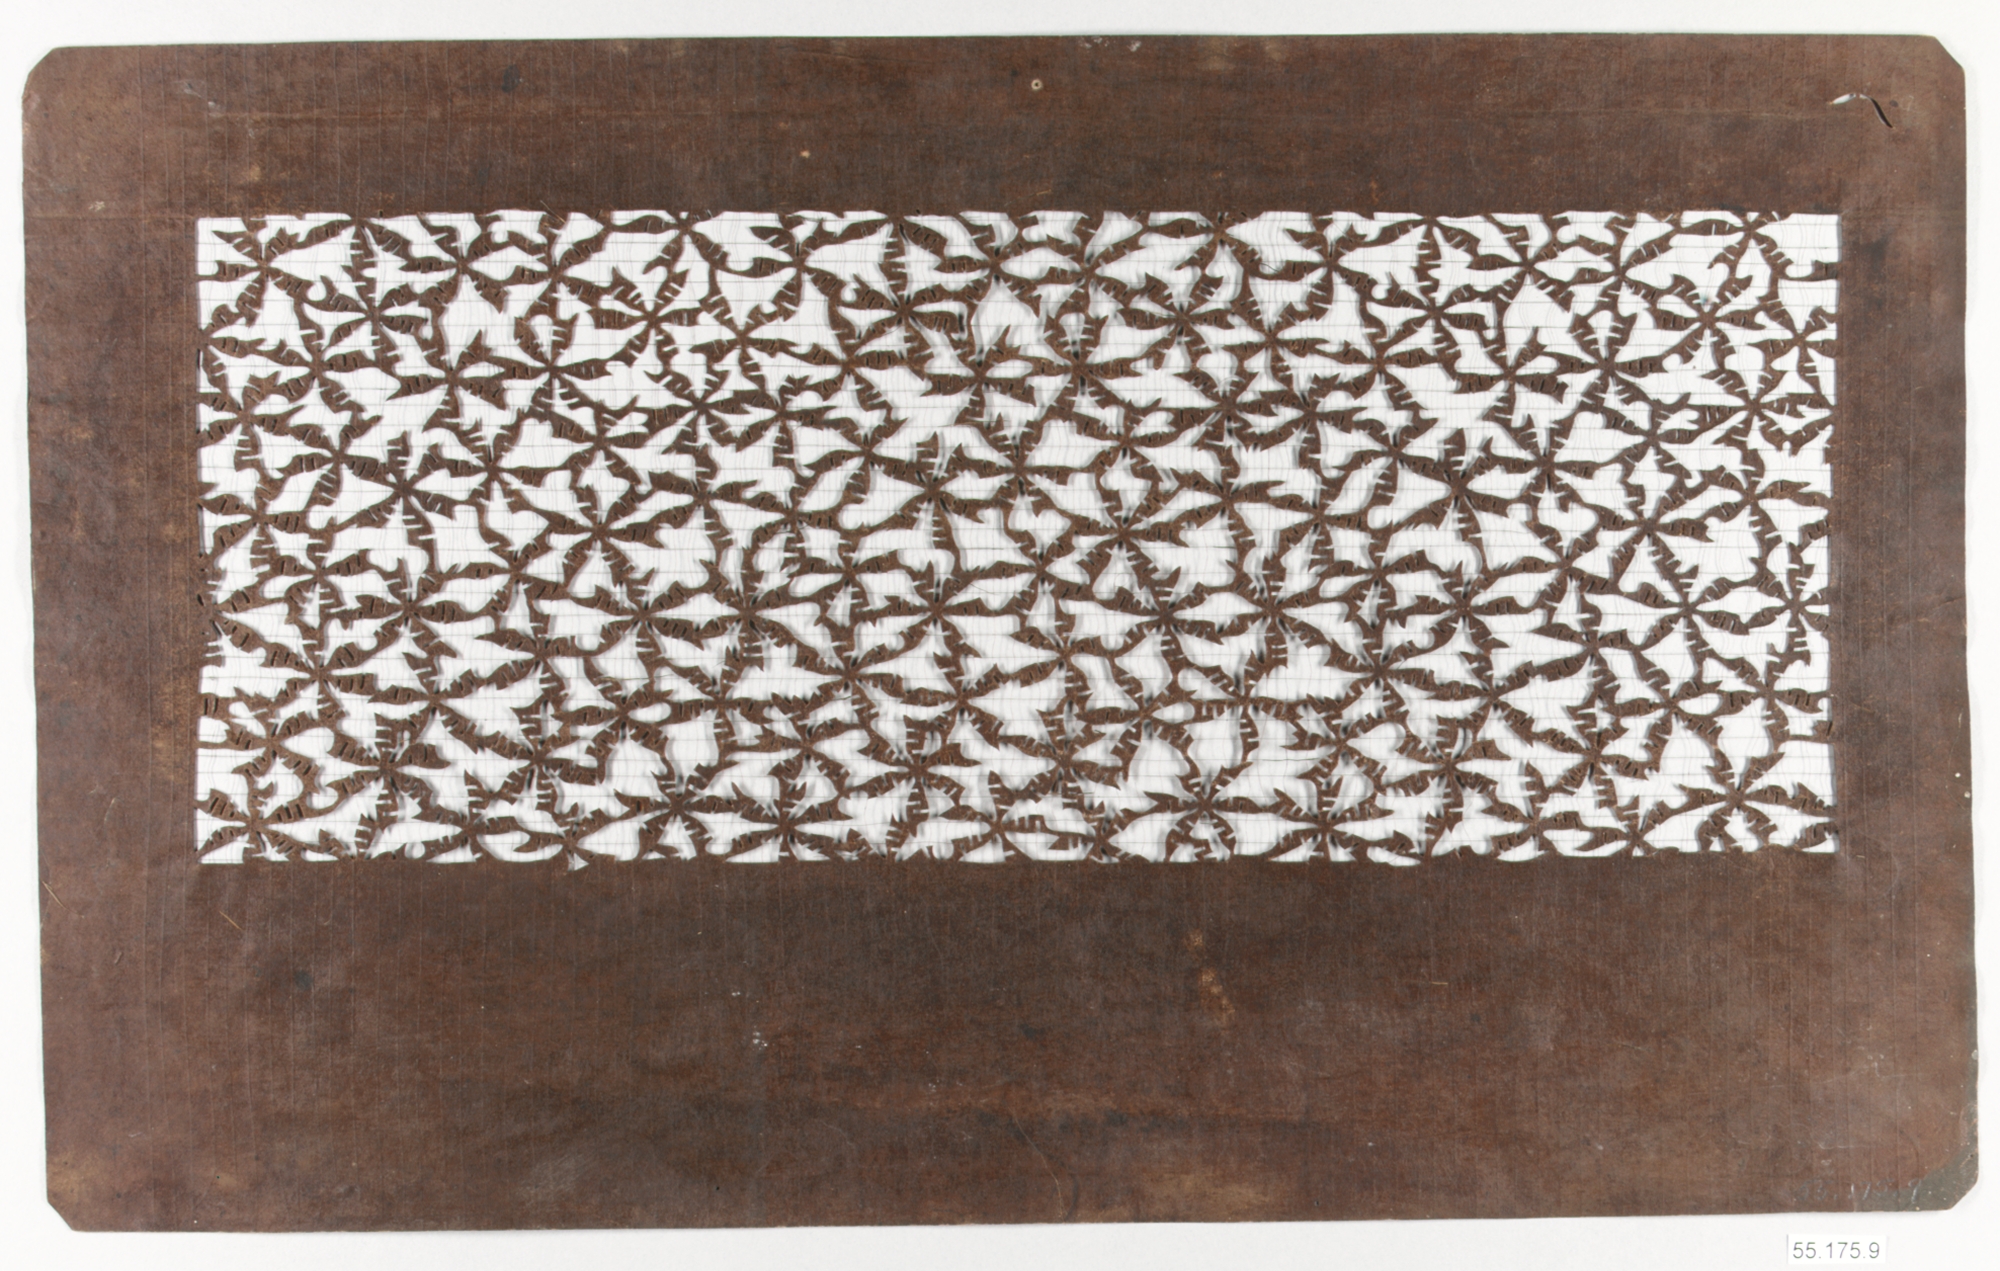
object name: stencil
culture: japanese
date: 1801-1900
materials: paper